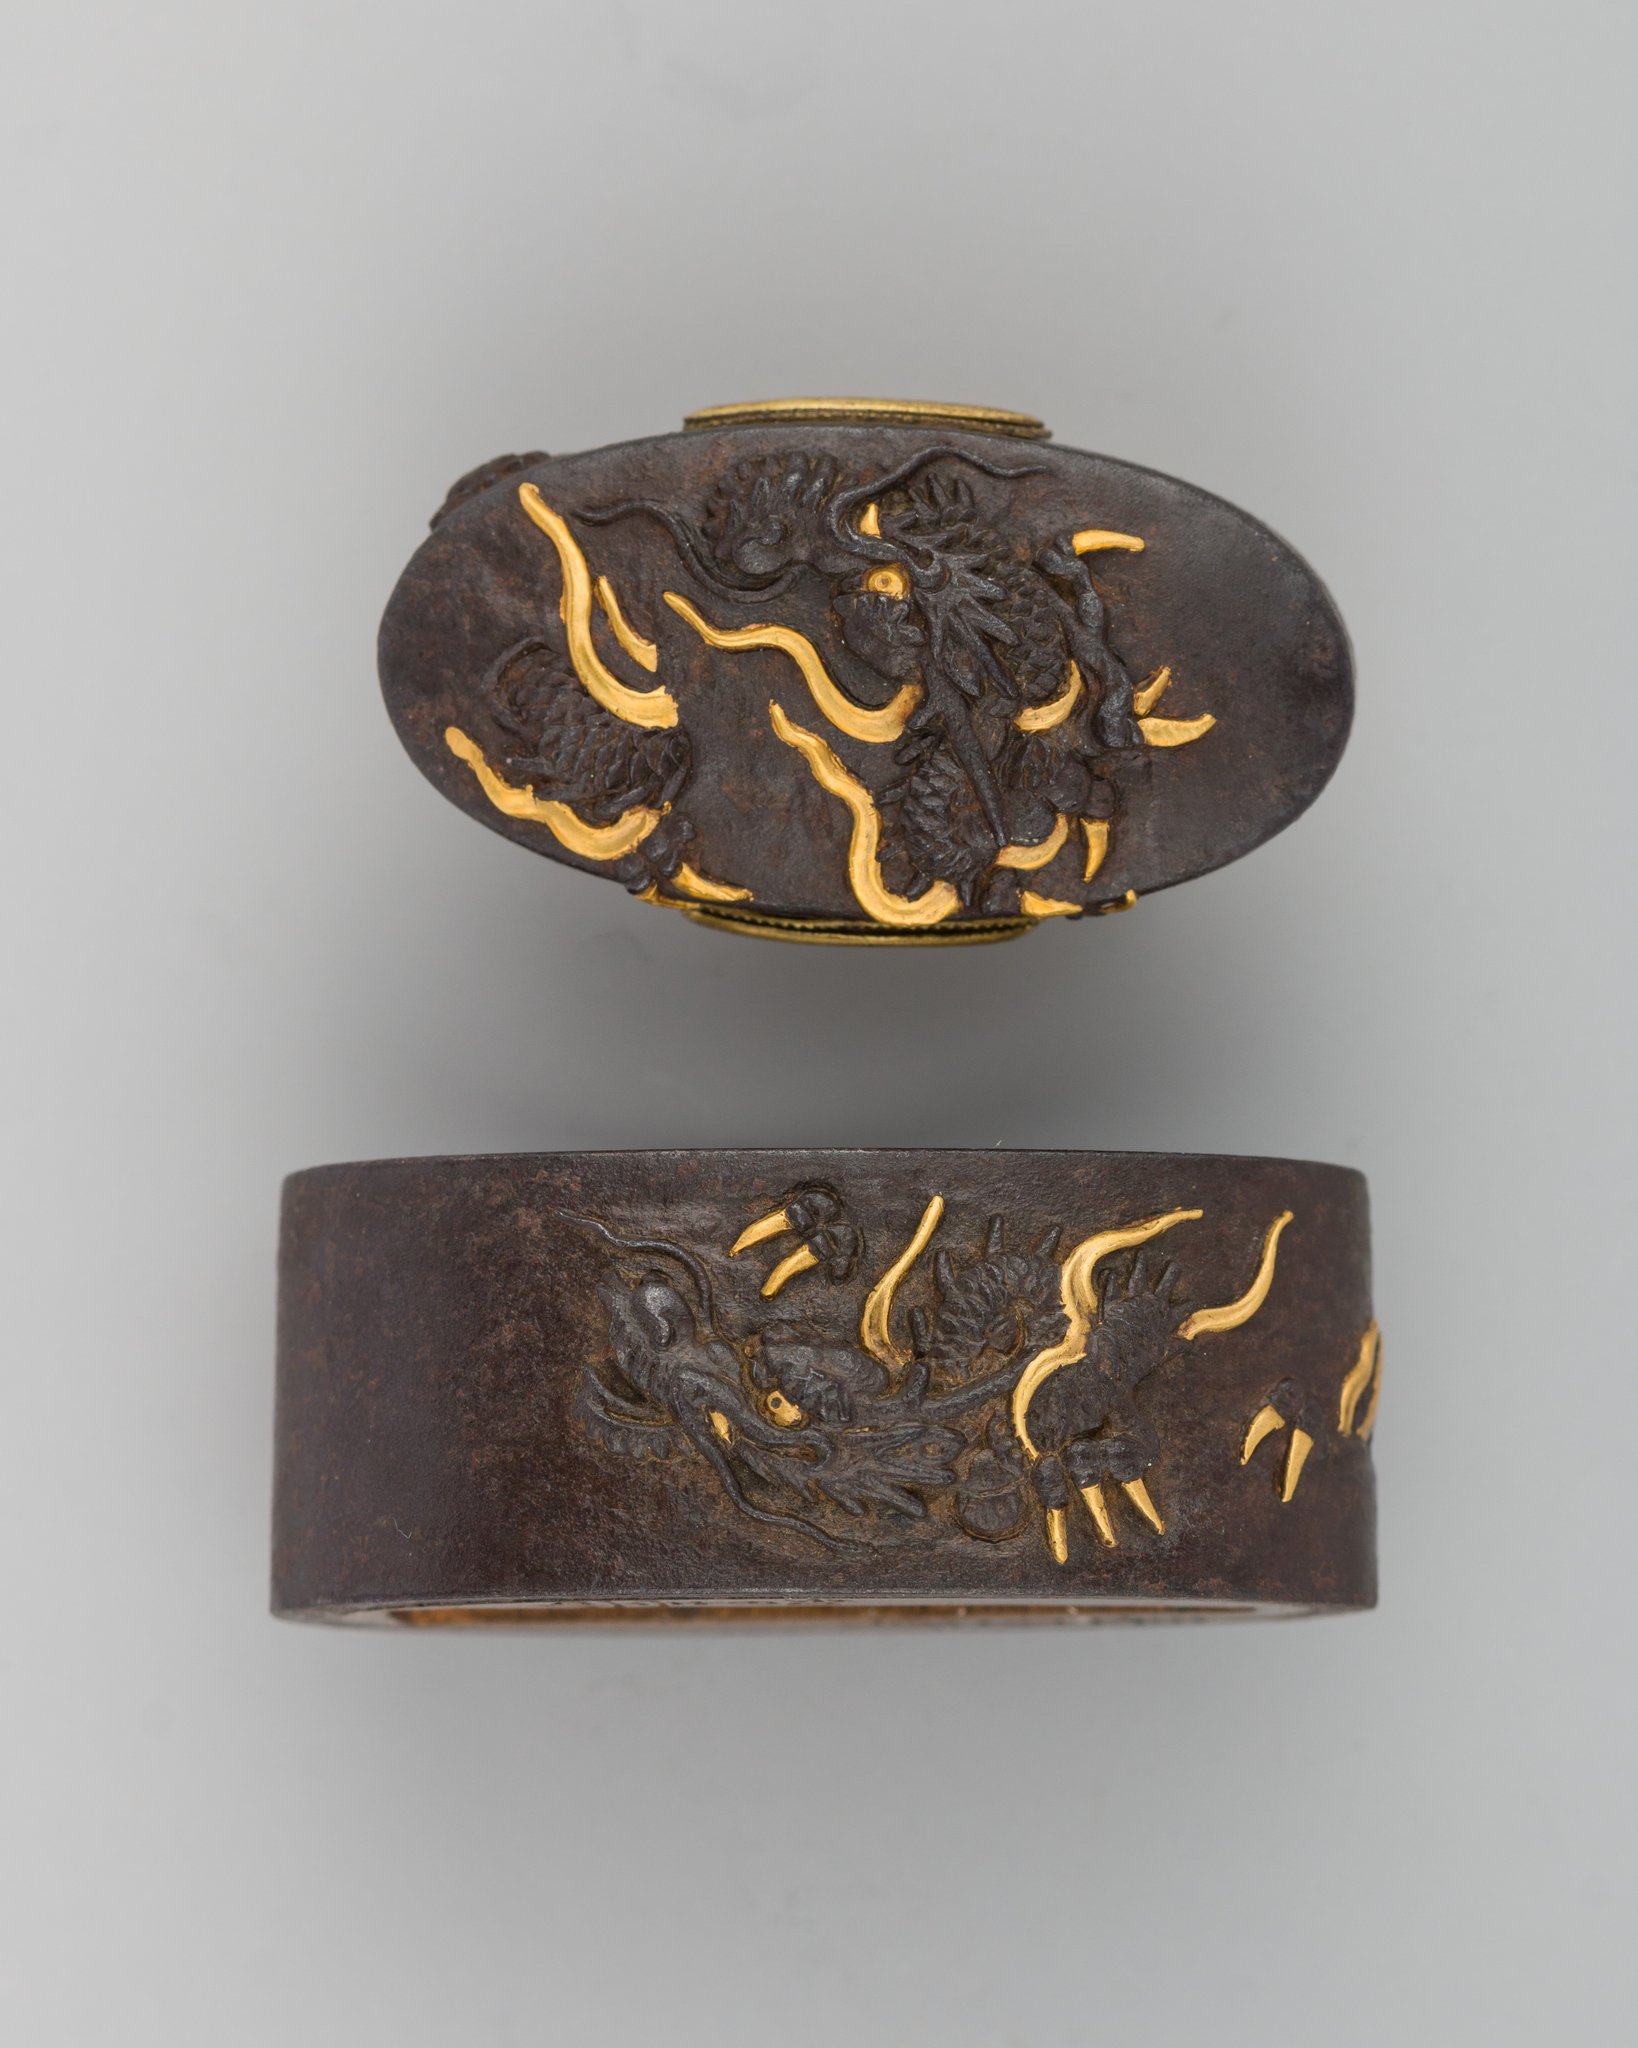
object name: sword hilt collar and pommel fuchigashira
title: Sword-Hilt Collar and Pommel (Fuchigashira)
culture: japanese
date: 1801-1833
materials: copper, gold, iron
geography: japan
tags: dragons